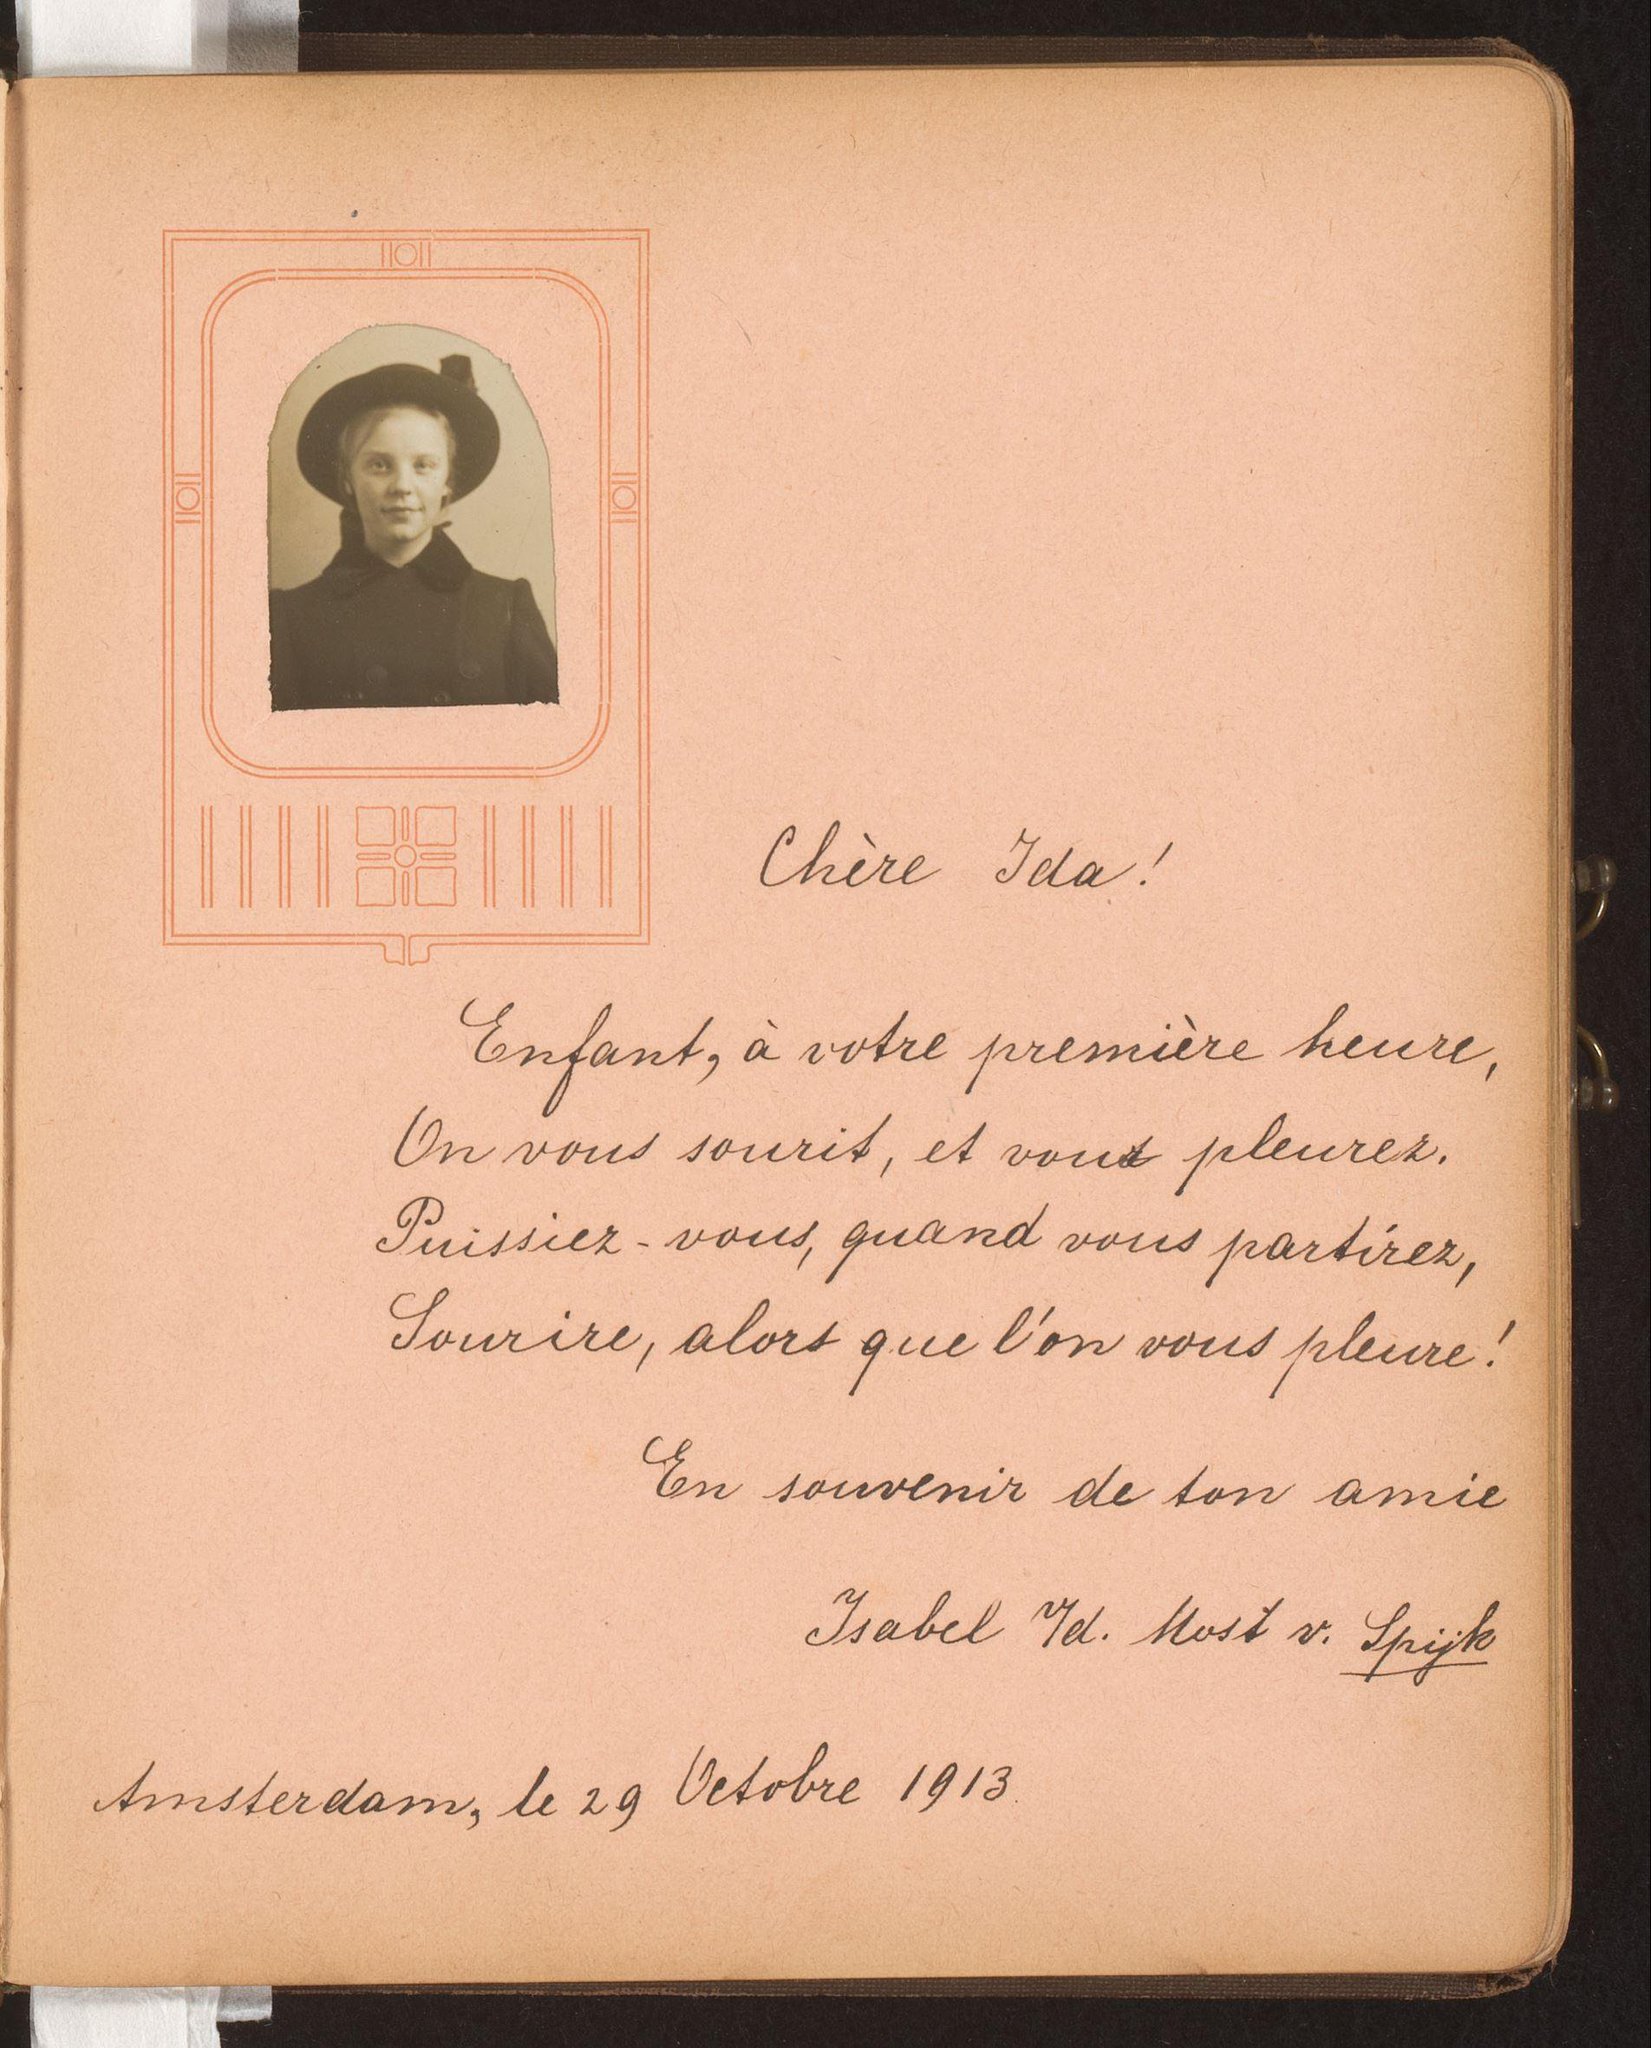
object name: album leaf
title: Portret van een jonge vrouw met hoed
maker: Anonymous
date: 1900-1913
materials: photographic support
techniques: gelatin silver print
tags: adolescent, young woman, maiden, head-gear, historical persons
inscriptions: annotation: ‘Chère Ida/ (...)’